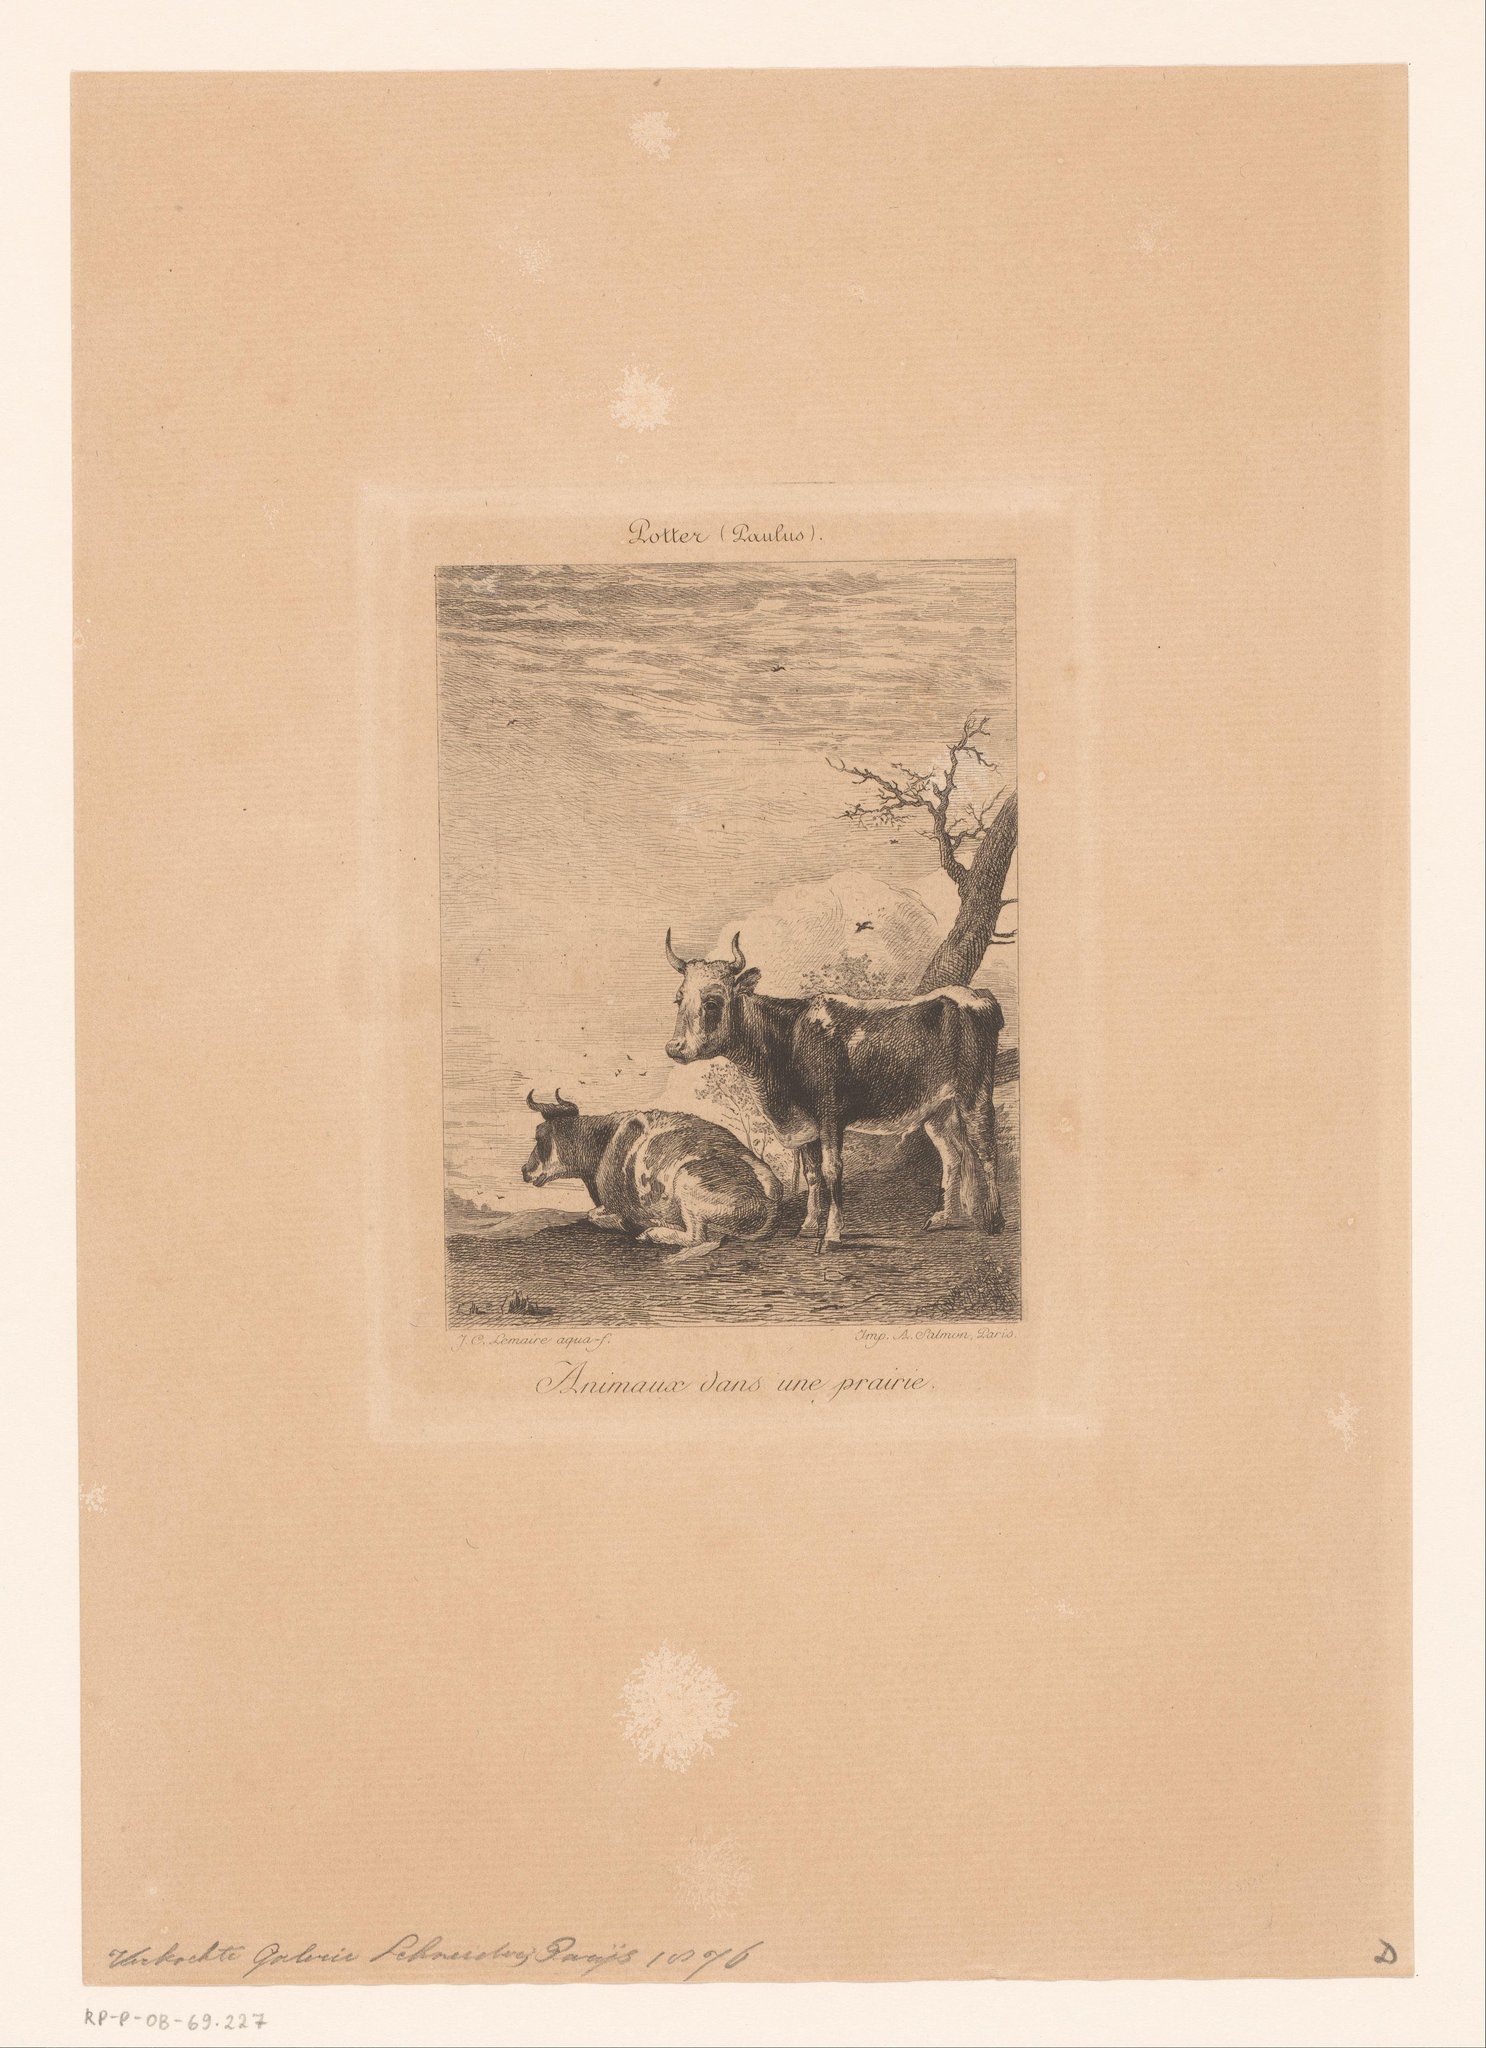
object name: print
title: Twee koeien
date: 1835-1925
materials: paper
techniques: drypoint, engraving, etching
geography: paris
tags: cow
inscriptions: collector's mark: Lugt 2228